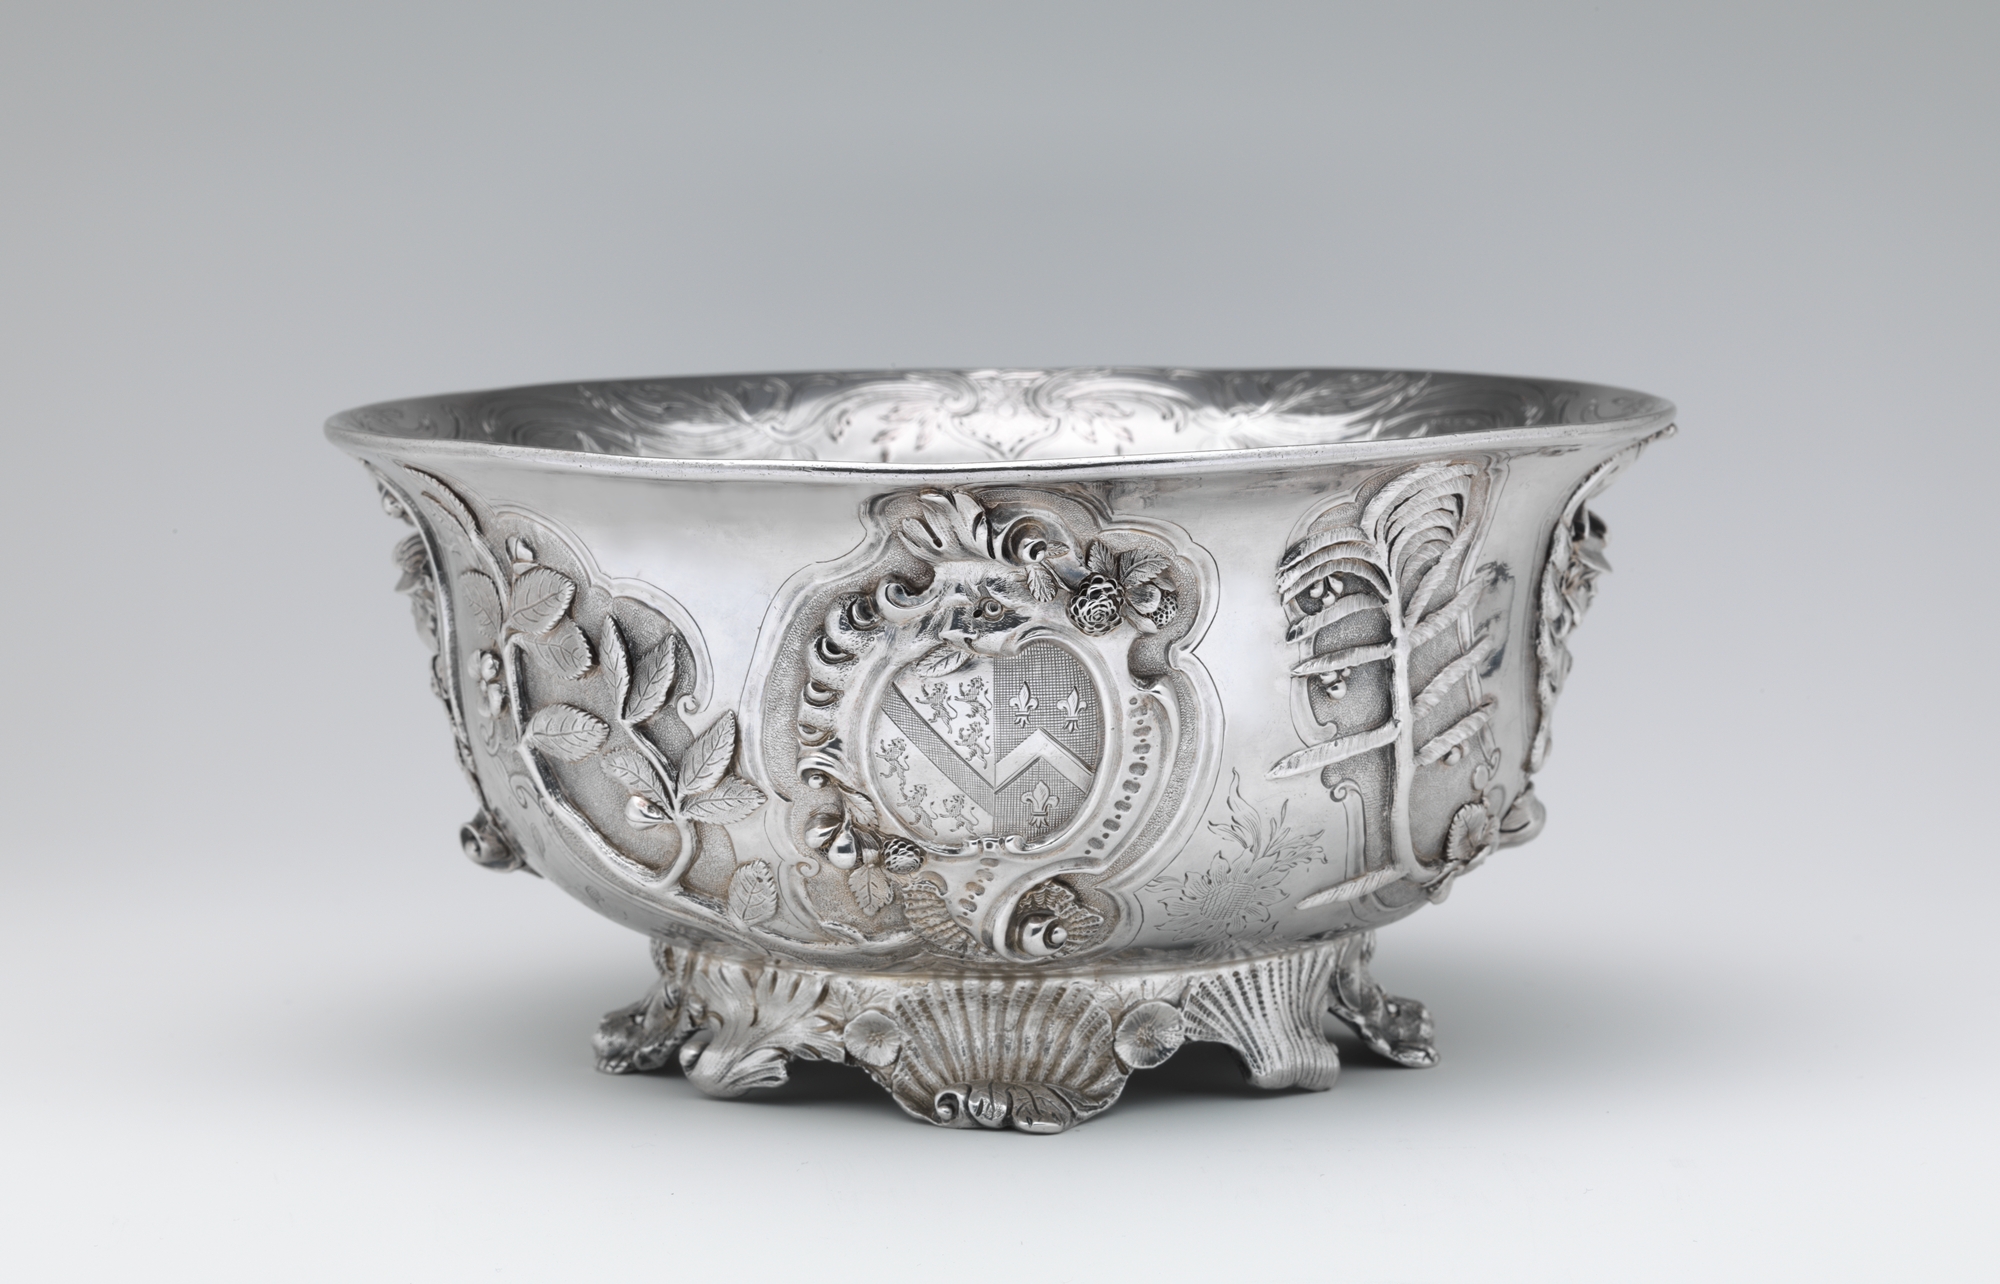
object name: bowl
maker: paul de lamerie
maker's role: maker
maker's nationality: british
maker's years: 1688-1751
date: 1744-1745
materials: silver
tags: faces